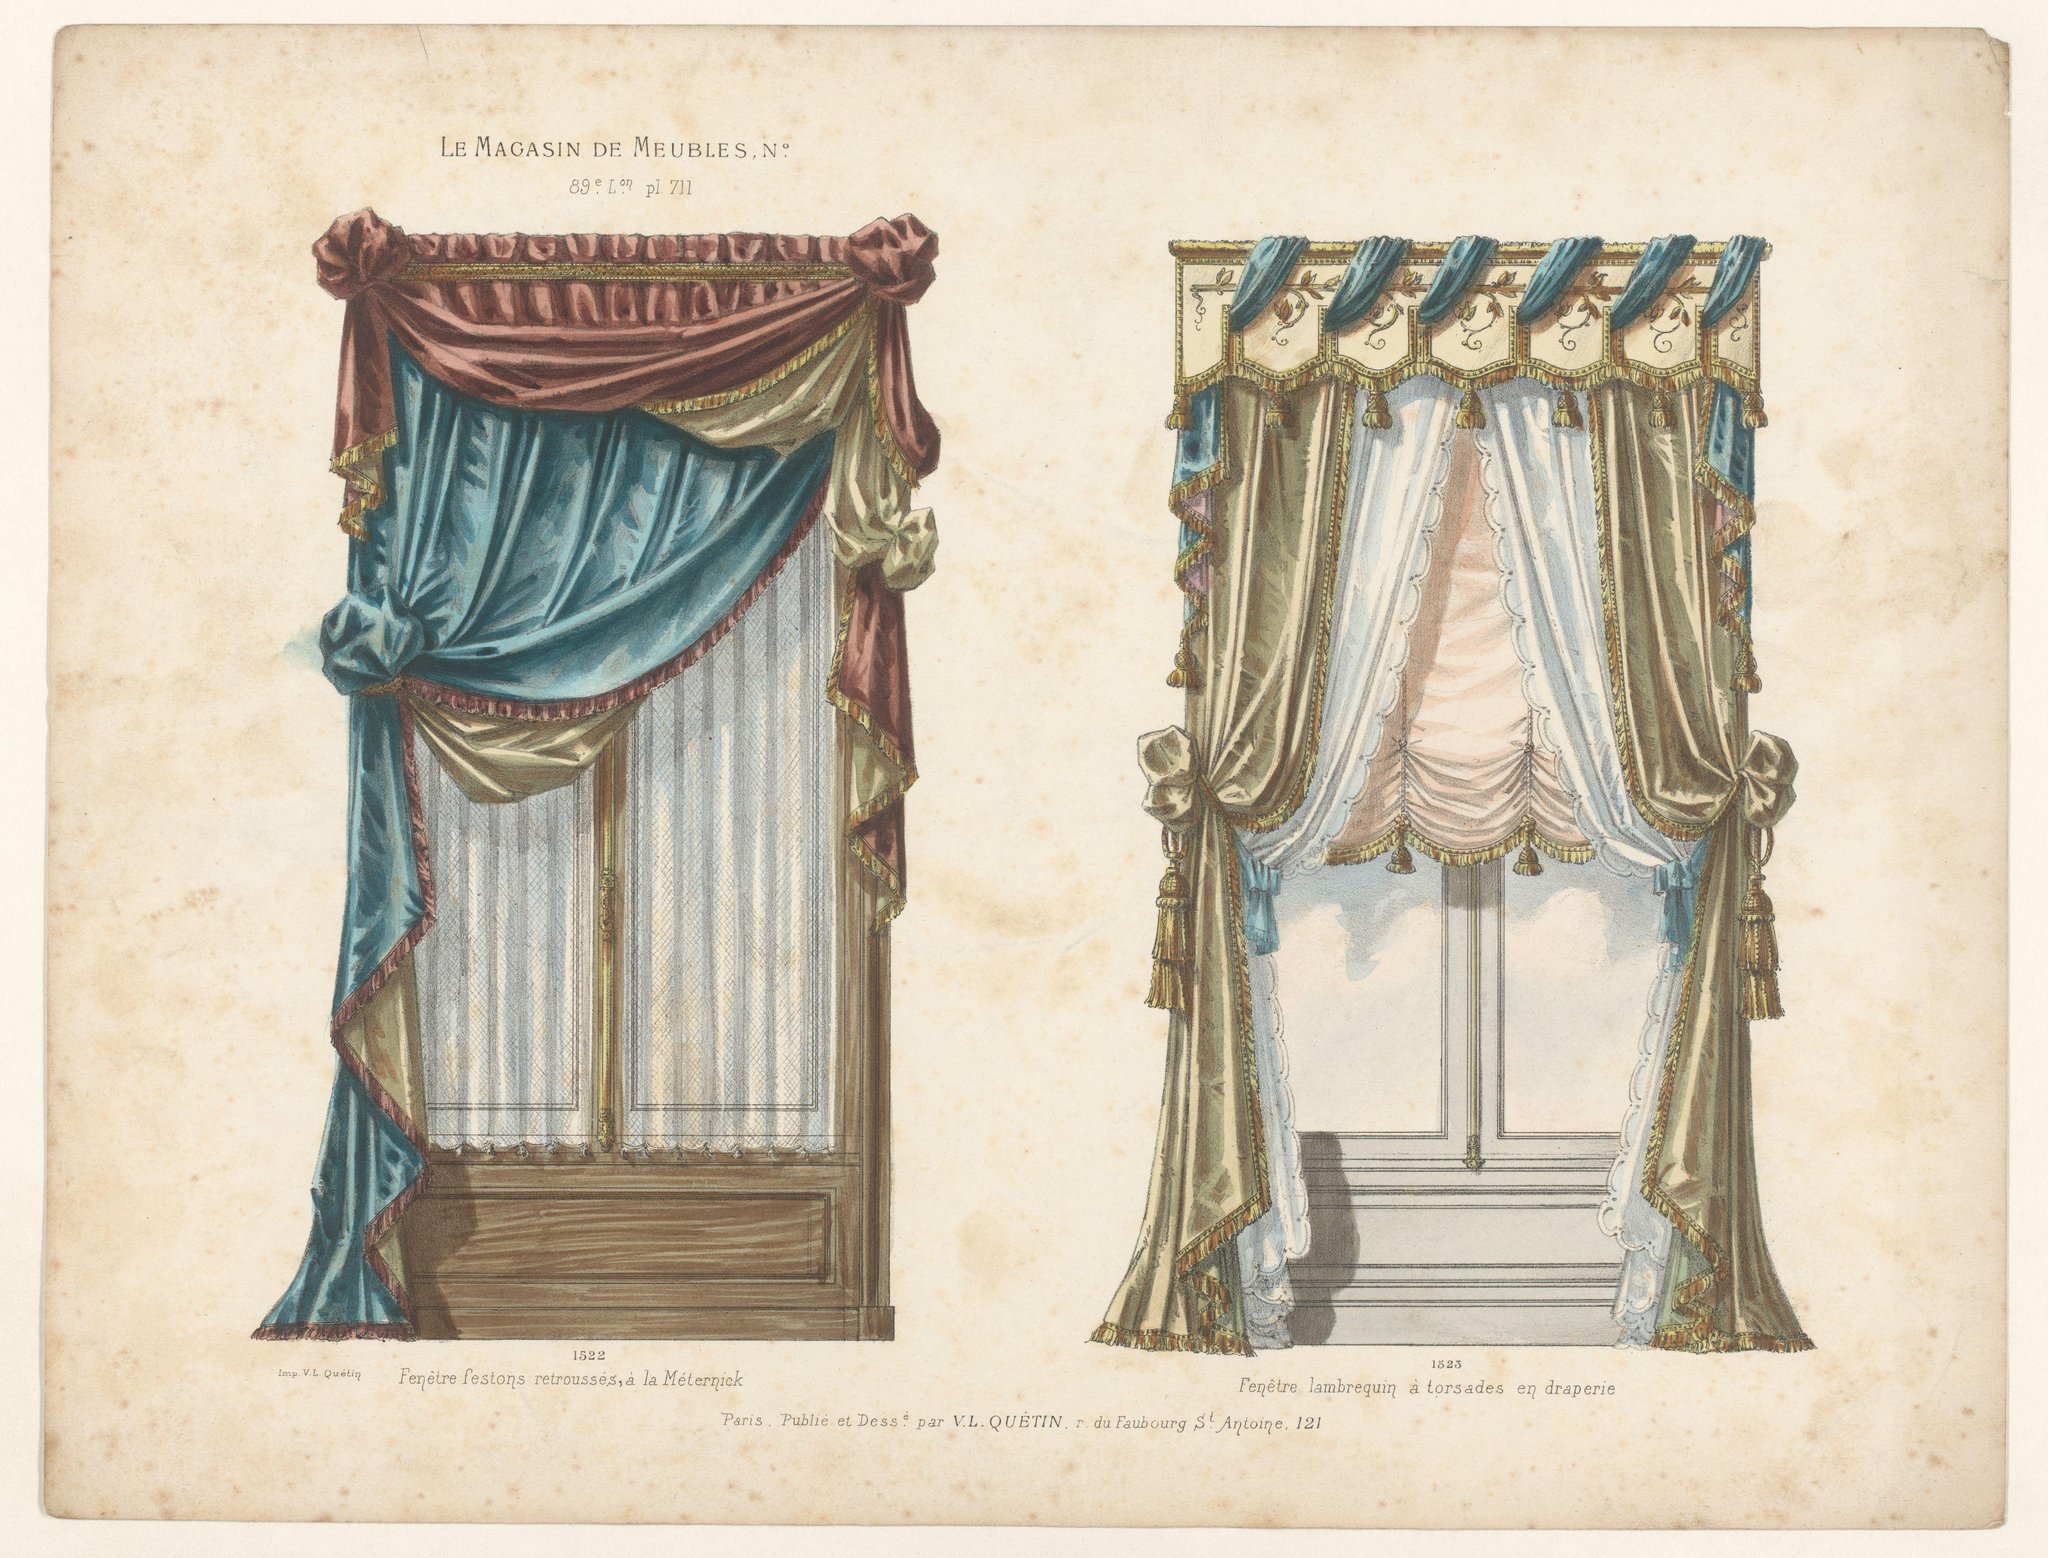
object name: print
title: Le Magasin de Meubles No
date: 1878-1904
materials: paper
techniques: hand coloring, lithograph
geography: paris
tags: window, hangings and drapery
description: Twee vensters met gedrapeerde gordijnen. Prent uit 89e Livraison.